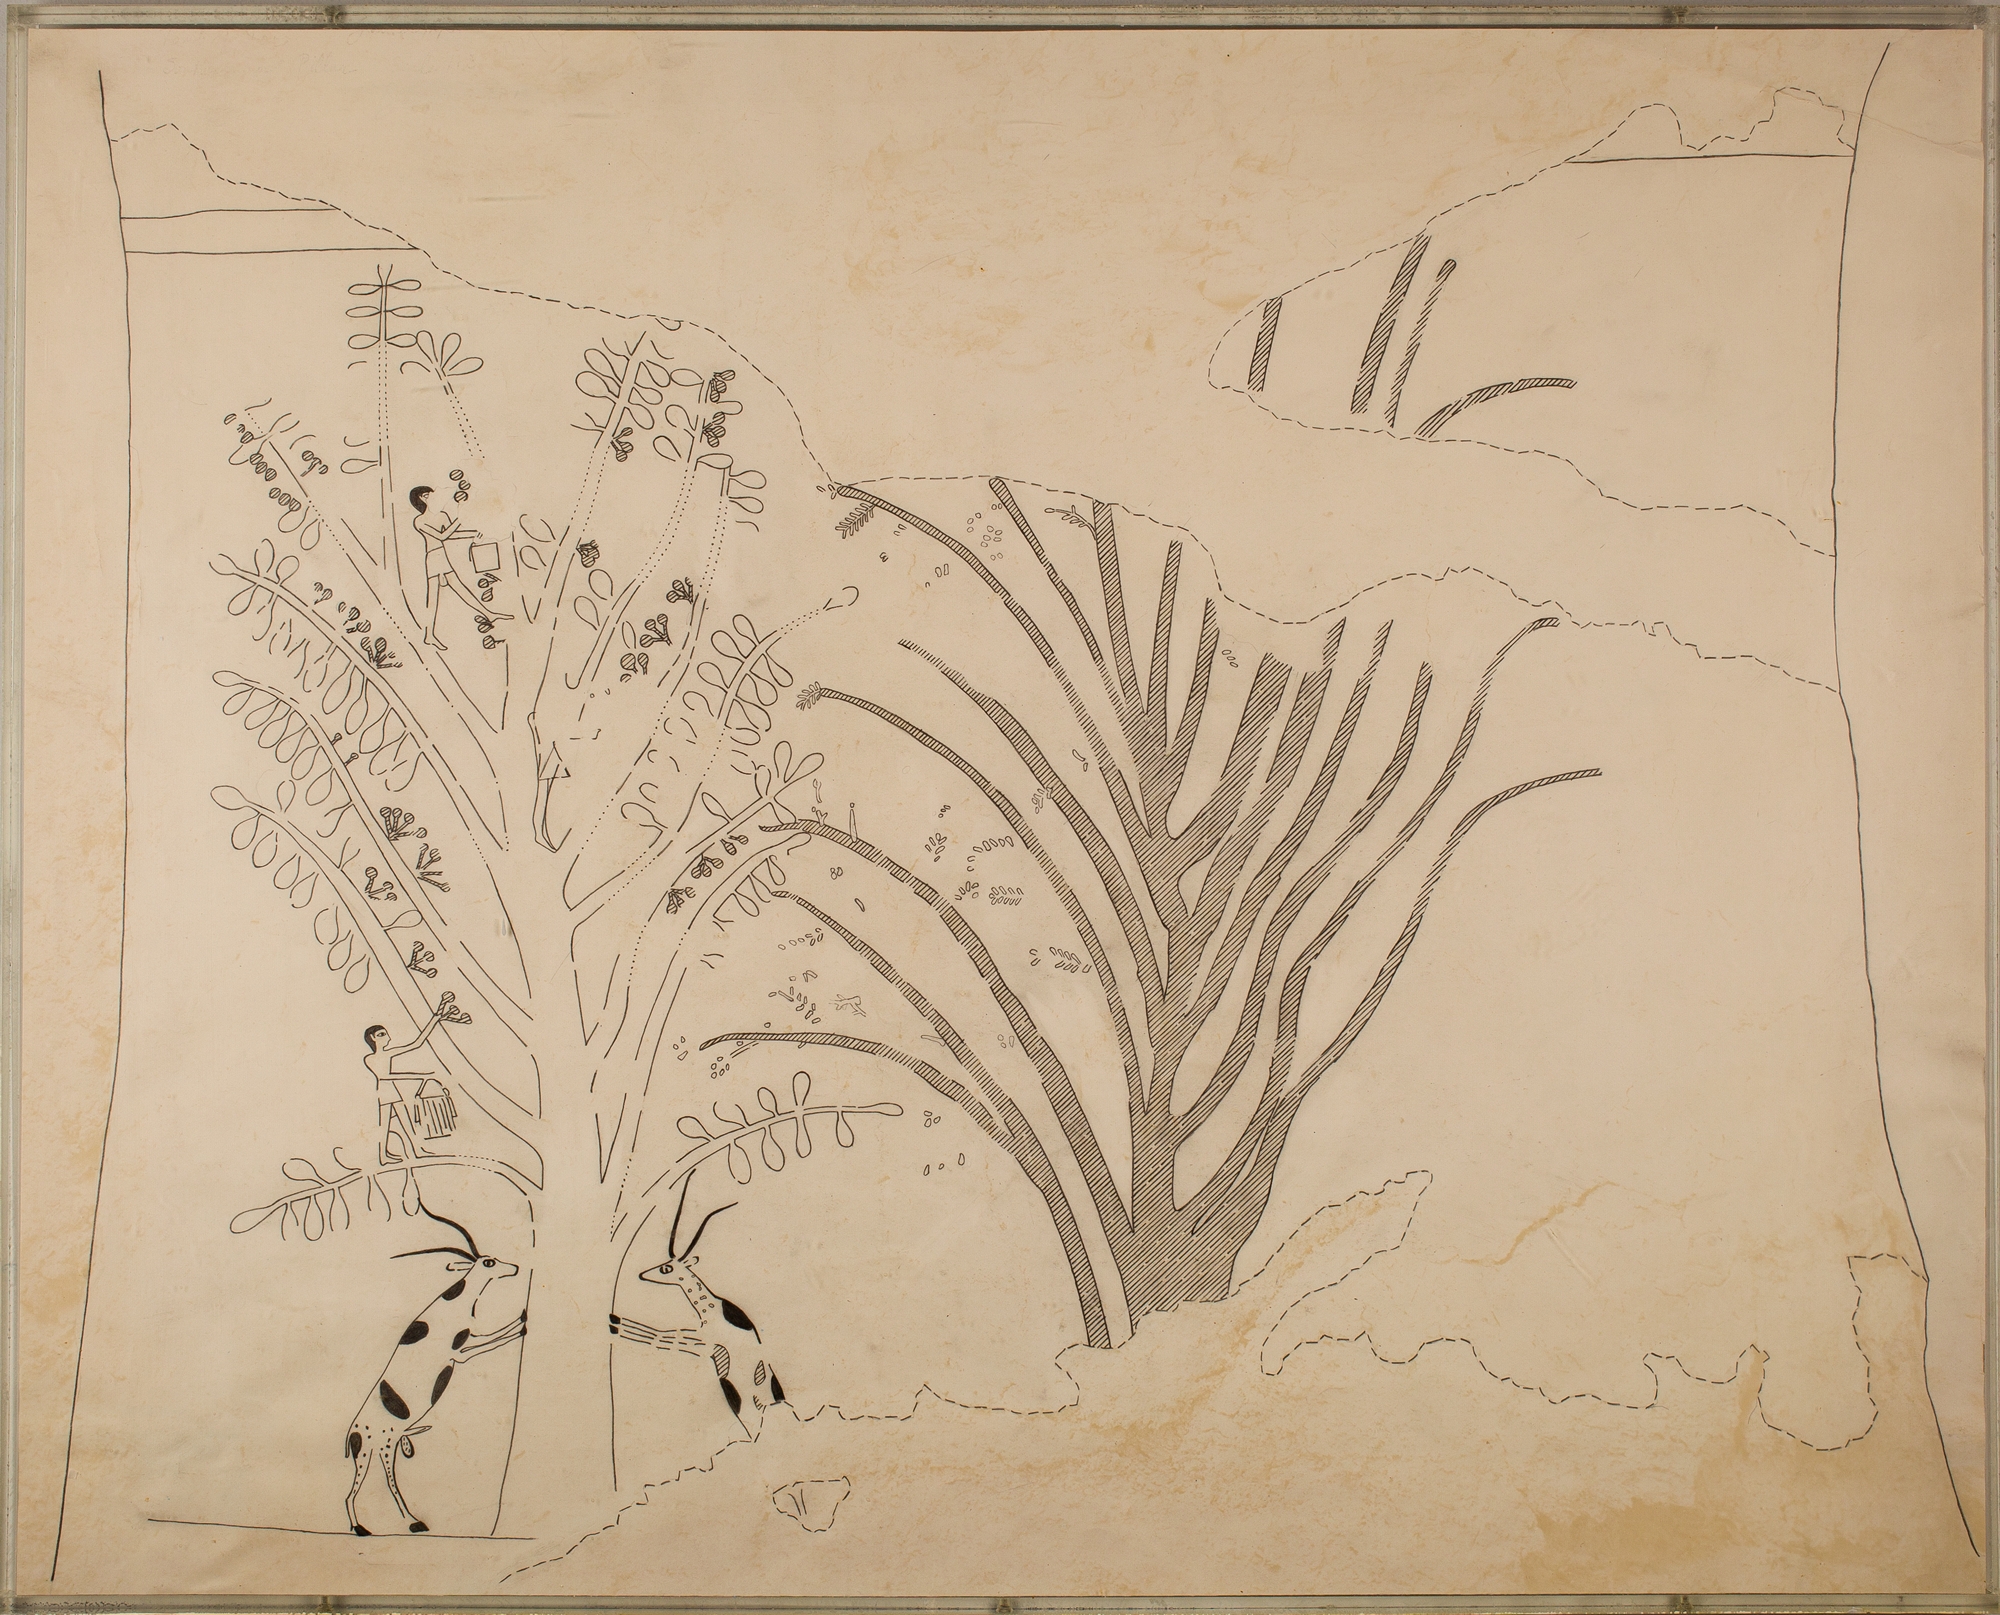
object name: facsimile, djari tt 366, sicamore fig tree, goat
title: Harvesting Sicamore Figs, Tomb of Djari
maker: unknown copyist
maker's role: artist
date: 2050-2000 BCE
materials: ink, paper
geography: egypt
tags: deer,trees